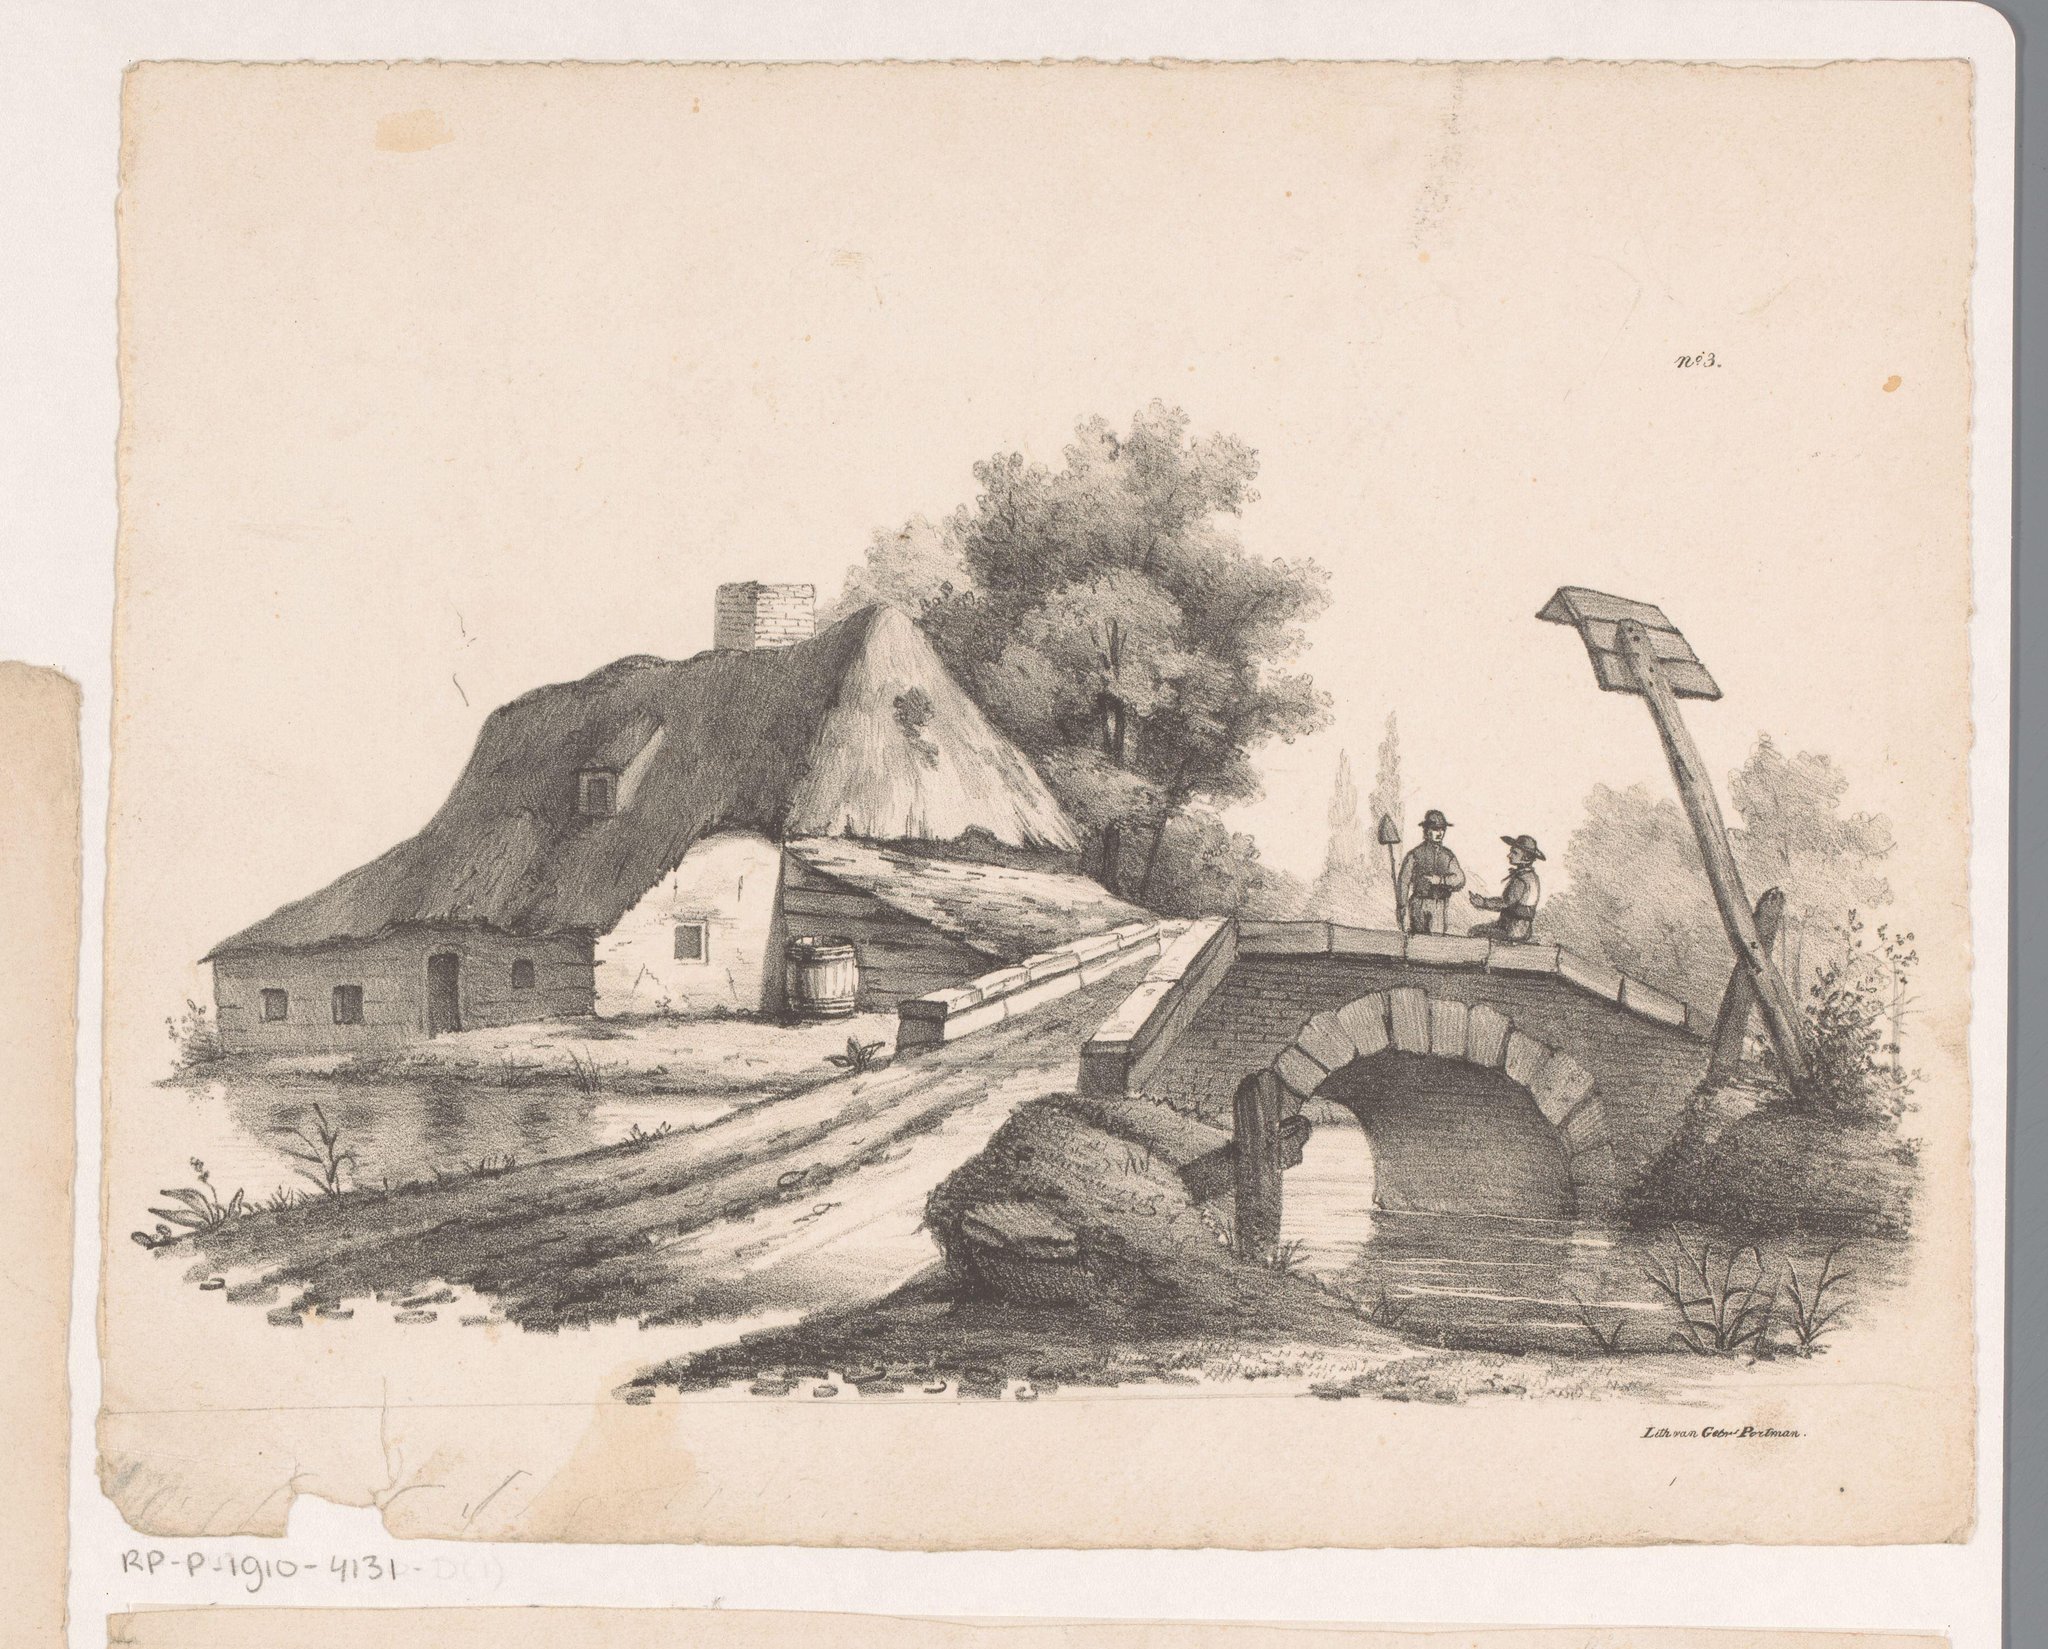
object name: print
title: Twee figuren op een brug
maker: Anonymous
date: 1827-1828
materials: paper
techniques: lithograph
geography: amsterdam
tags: bridge, landscapes (+ landscape with figures, staffage), farm or solitary house in landscape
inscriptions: collector's mark: Lugt 2228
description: Twee mannen in gesprek op een burg over een rivier. Links in de achtergrond een boerderij.